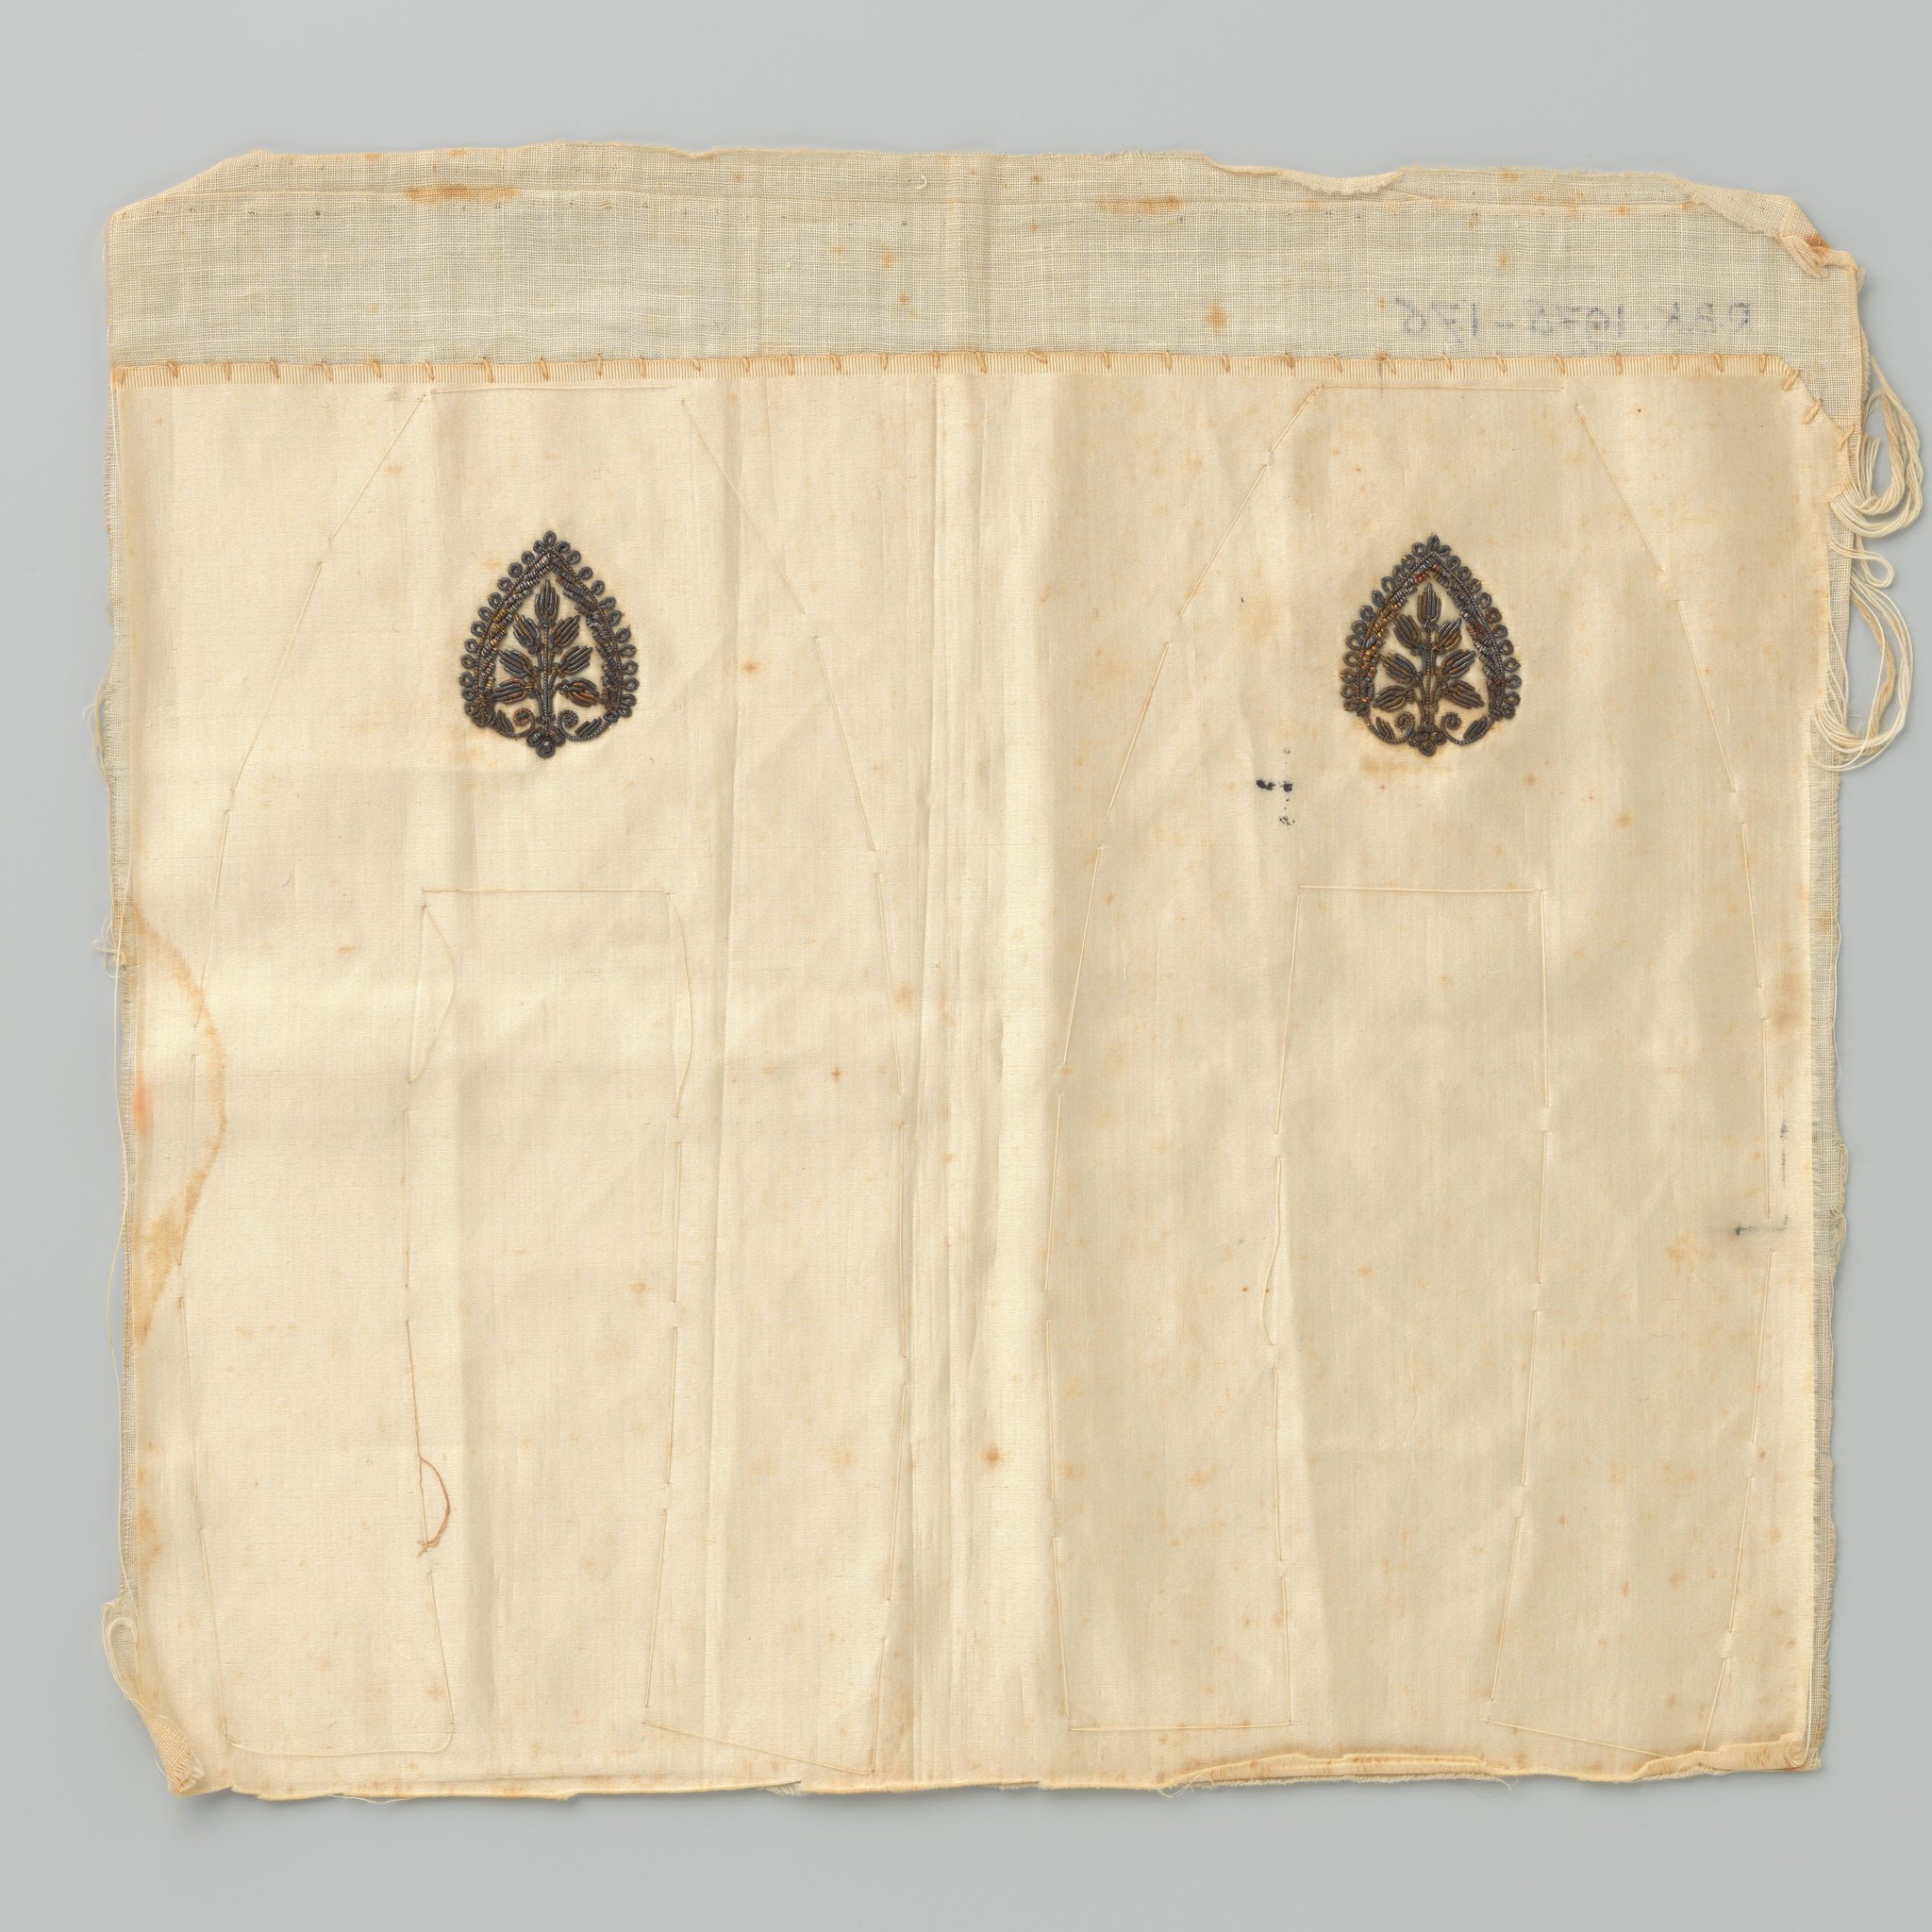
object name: voorblad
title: Ongenaaide of gezoolde balschoen of bruidsschoen van roomkleurige satijn met goudborduursel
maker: Anonymous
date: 1820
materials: gold thread, textile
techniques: embroidered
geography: netherlands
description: Balschoen of bruidsschoen, nog niet genaaid of gezoold, van roomkleurige satijn met goudborduursel. Model: hakloos model met vierkante neus; slechts in omtrek aangegeven met rijgdraad op een rechthoekige lap satijn die is gehecht op een voering van mul. Op het voorblad een palmet in spitsboog geborduurd van o.a. cannetille-gouddraad steken. In de mode van de Restauration. Nederland?, ca. 1820.